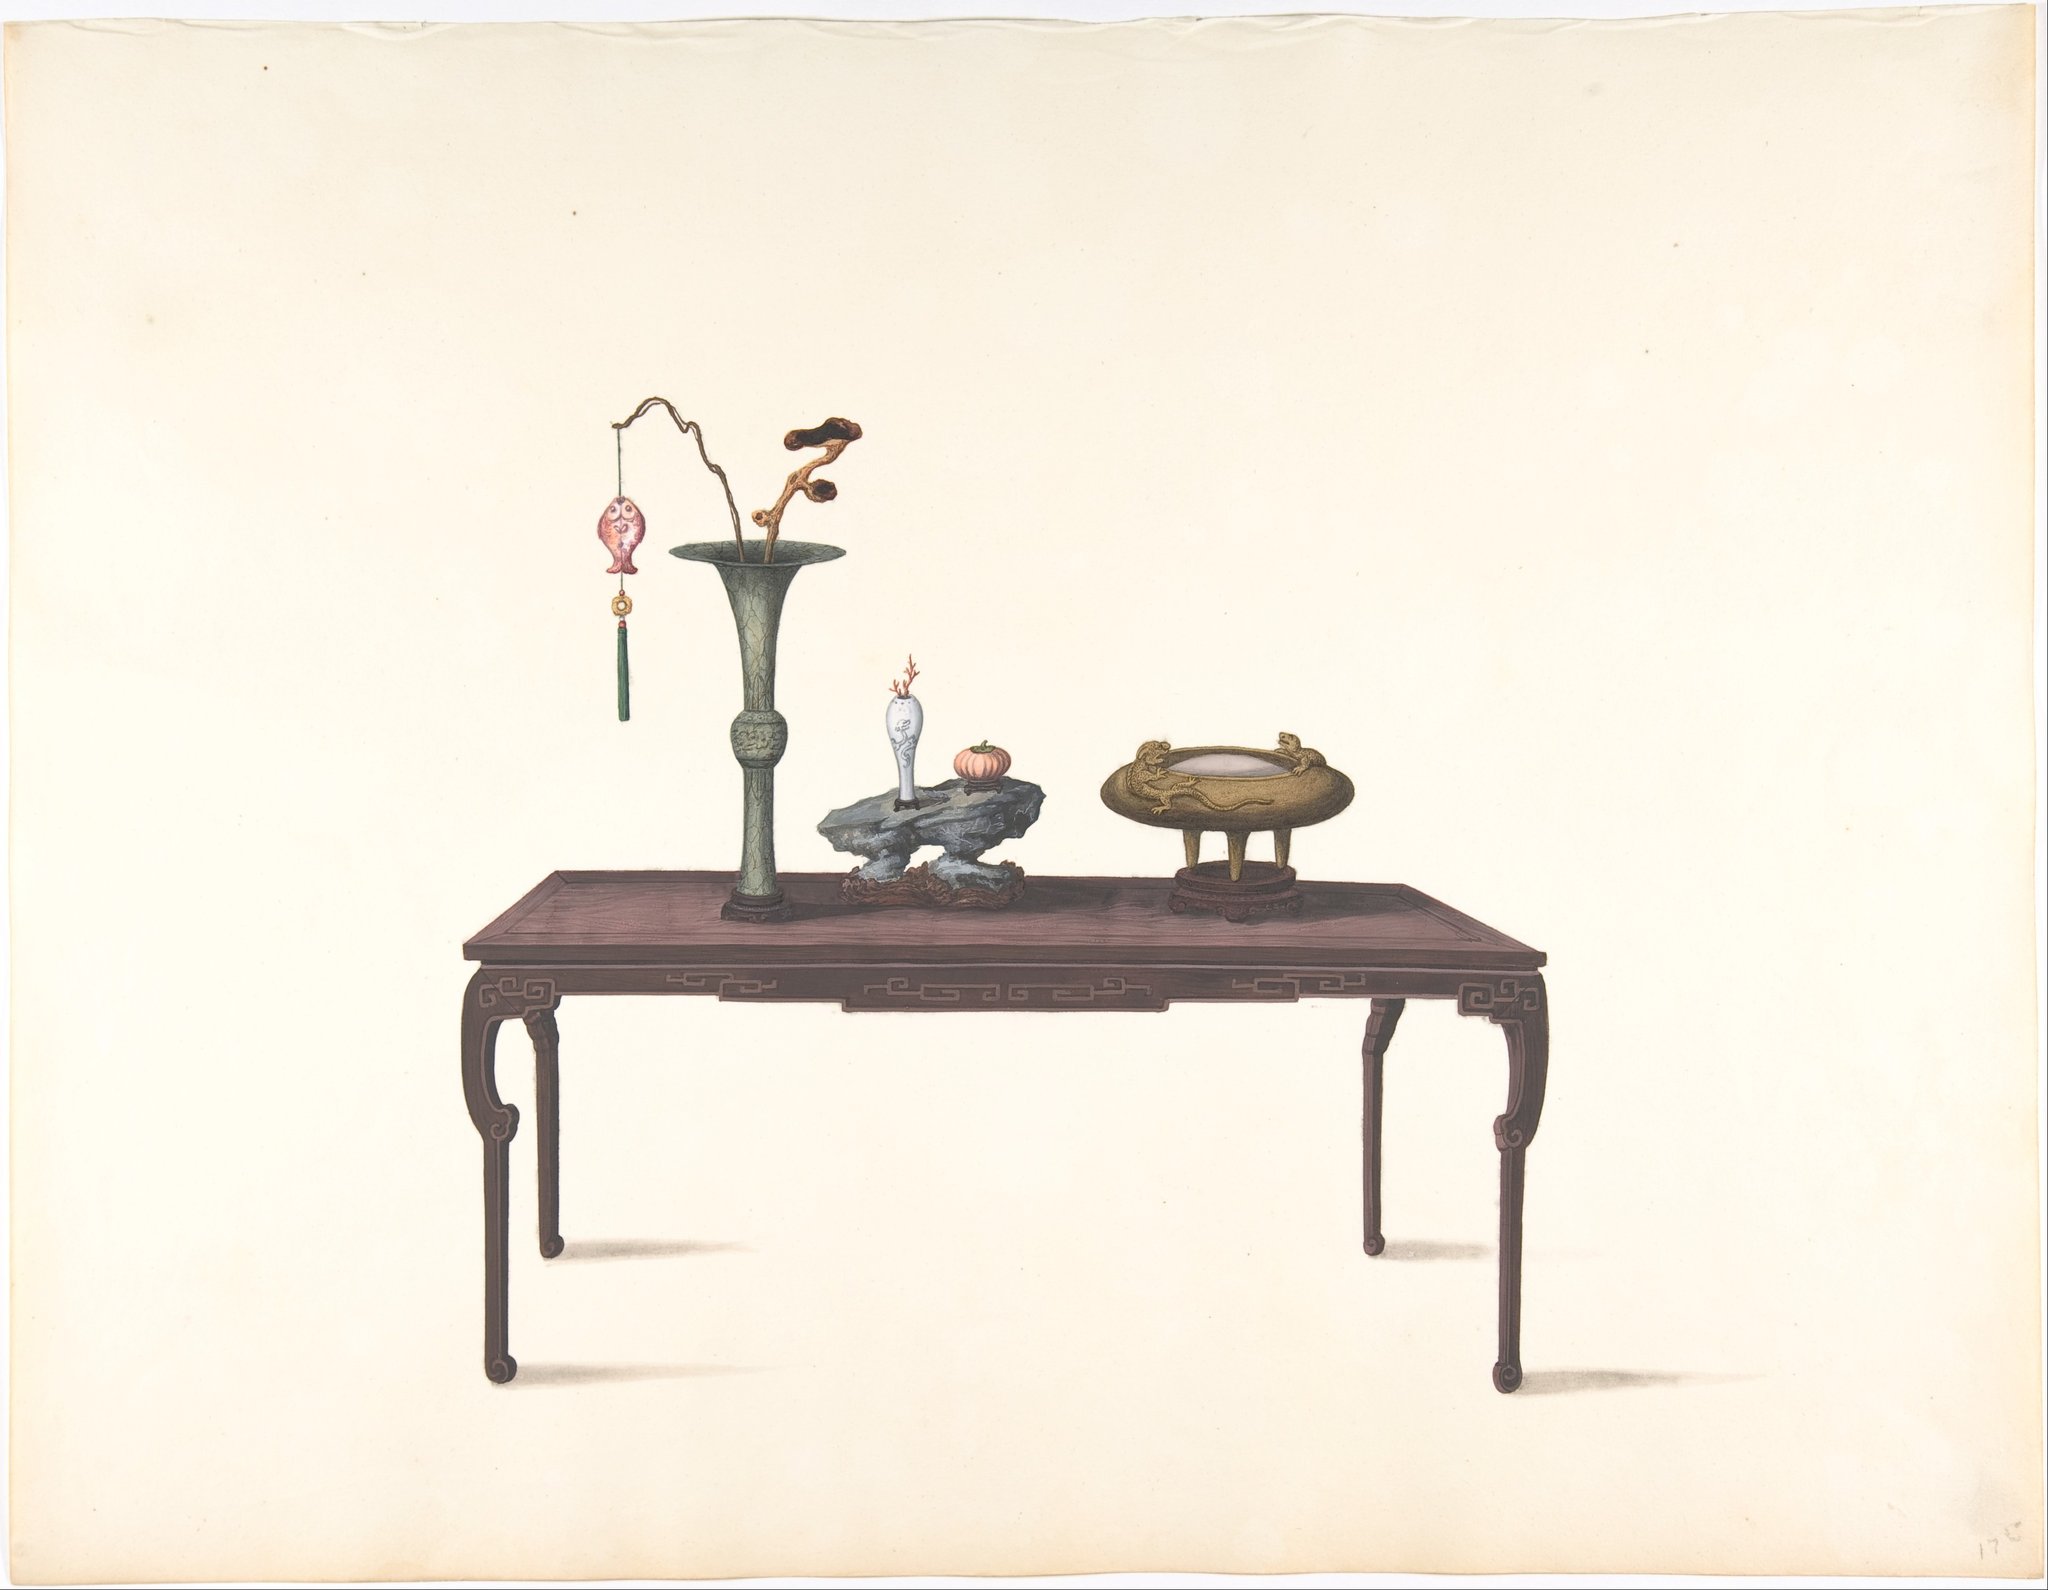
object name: drawing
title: Long Dark Table with Decorative Objects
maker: anonymous, chinese, 19th century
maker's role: artist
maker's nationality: chinese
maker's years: 1800-1900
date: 1801-1900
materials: gouache, ink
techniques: pen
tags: tables